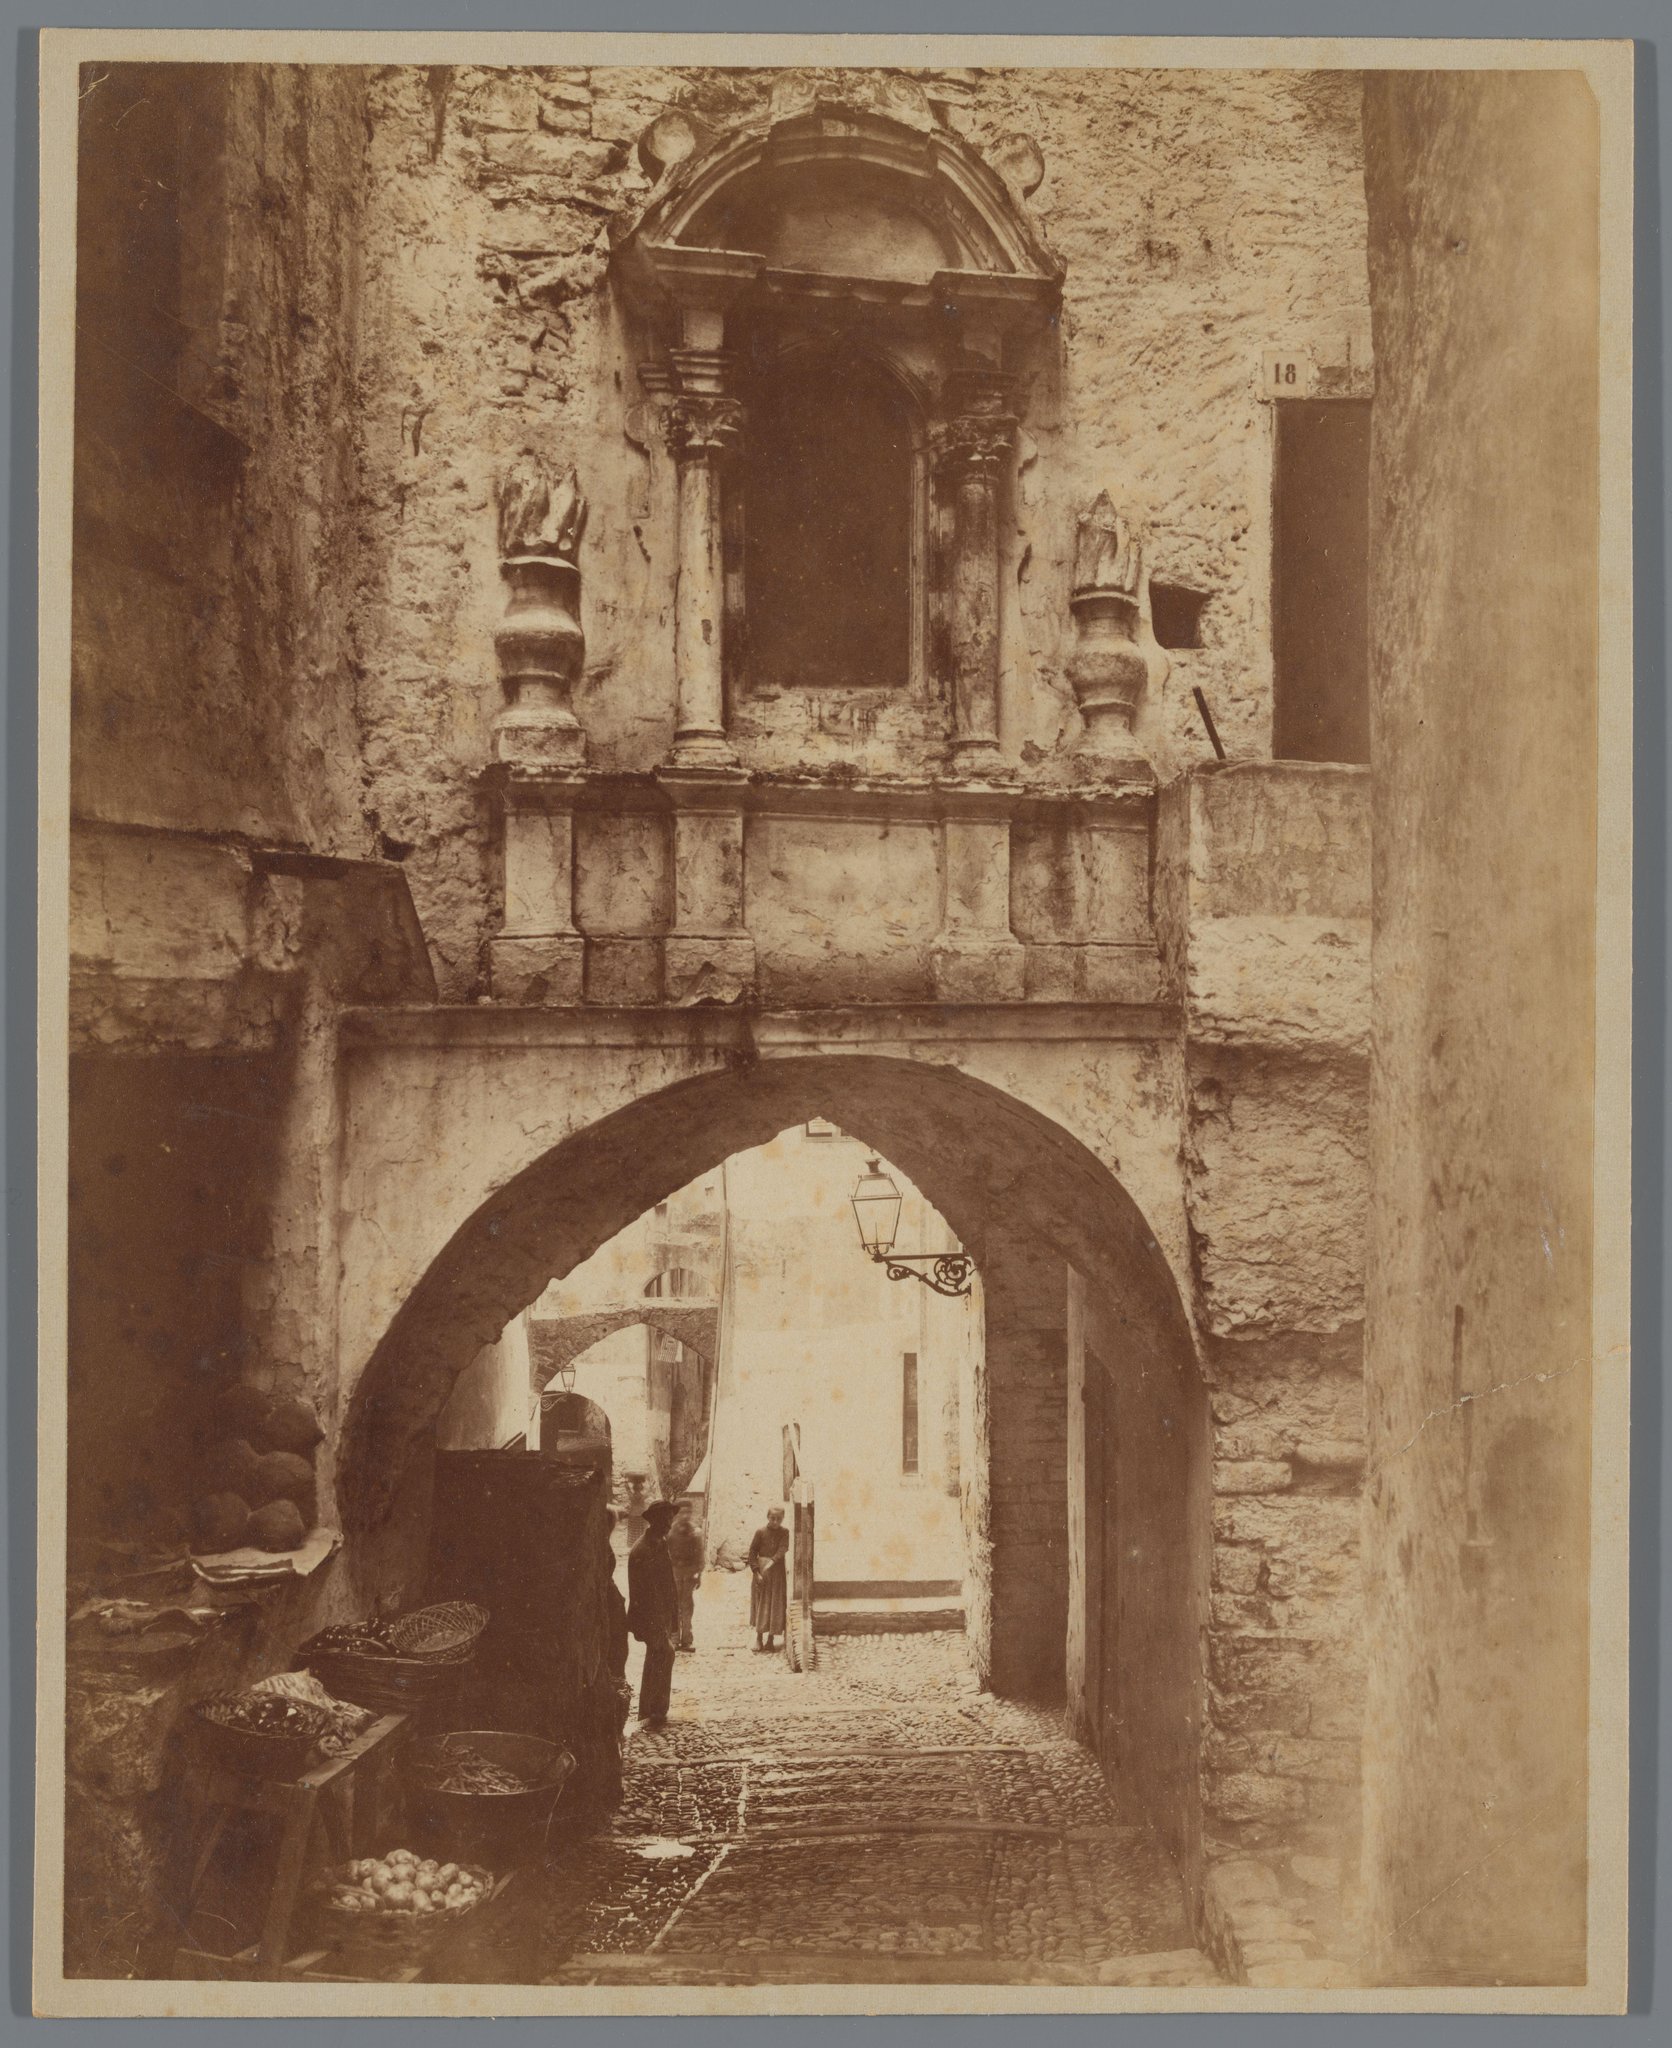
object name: photograph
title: Straat in Zuid-Europa of Noord-Afrika met fruit- en groenteverkoop onder een poort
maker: Anonymous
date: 1870-1900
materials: cardboard, paper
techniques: albumen print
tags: gate, entrance, street, fruits, vegetables and fruit; still life of vegetables and fruit